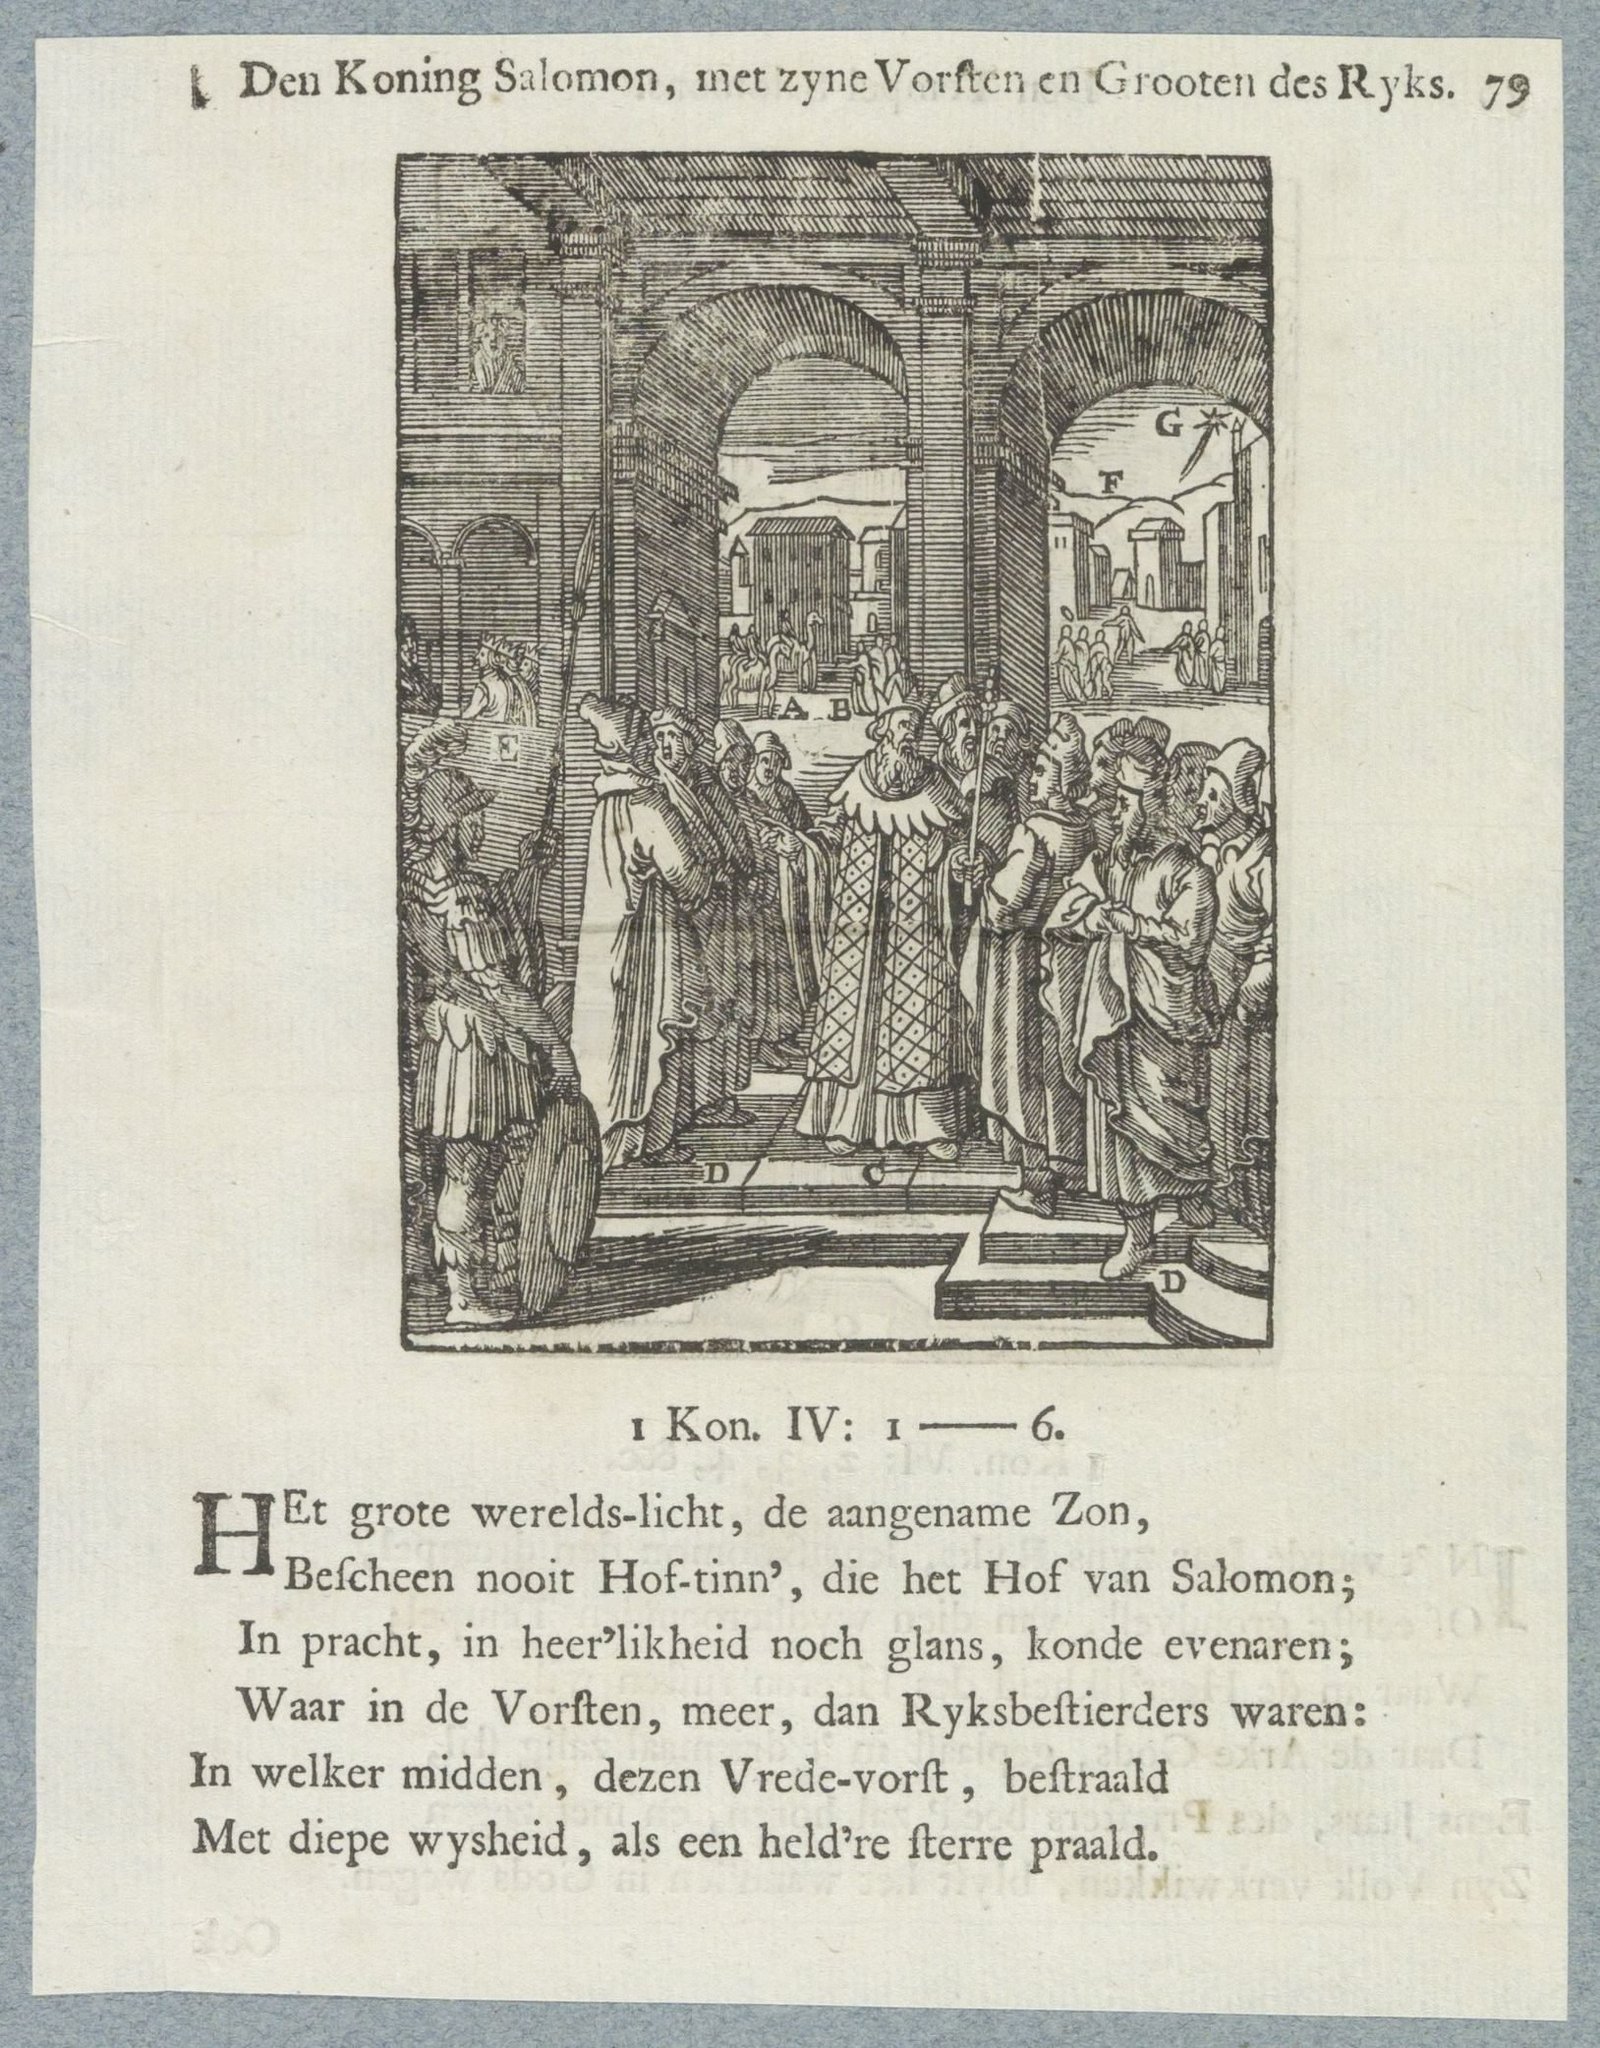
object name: book illustration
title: Aankomst van de koningen bij Herodes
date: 1629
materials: paper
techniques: letterpress printing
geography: amsterdam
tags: the arrival of the three wise men in bethlehem, politics of solomon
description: De prent is afkomstig uit: Bybels Lusthof. Amsterdam, J. Klooster, 1740. Ze werd als eerste gebruikt als afbeelding van de aankomst van de koningen bij Herodes gebruikt in: Der Zielen Lust-hof. Leuven, I.Jacbosz voor P.J. Paets [= Amsterdam, P.J. Paets], 1629. De voorstelling is gekopieerd naar een prent van Hieronymus Wierix voor: Nadal, Jerónimo. Evangelicae Historiae Imagines. Antwerpen, M. Nutius, 1593.